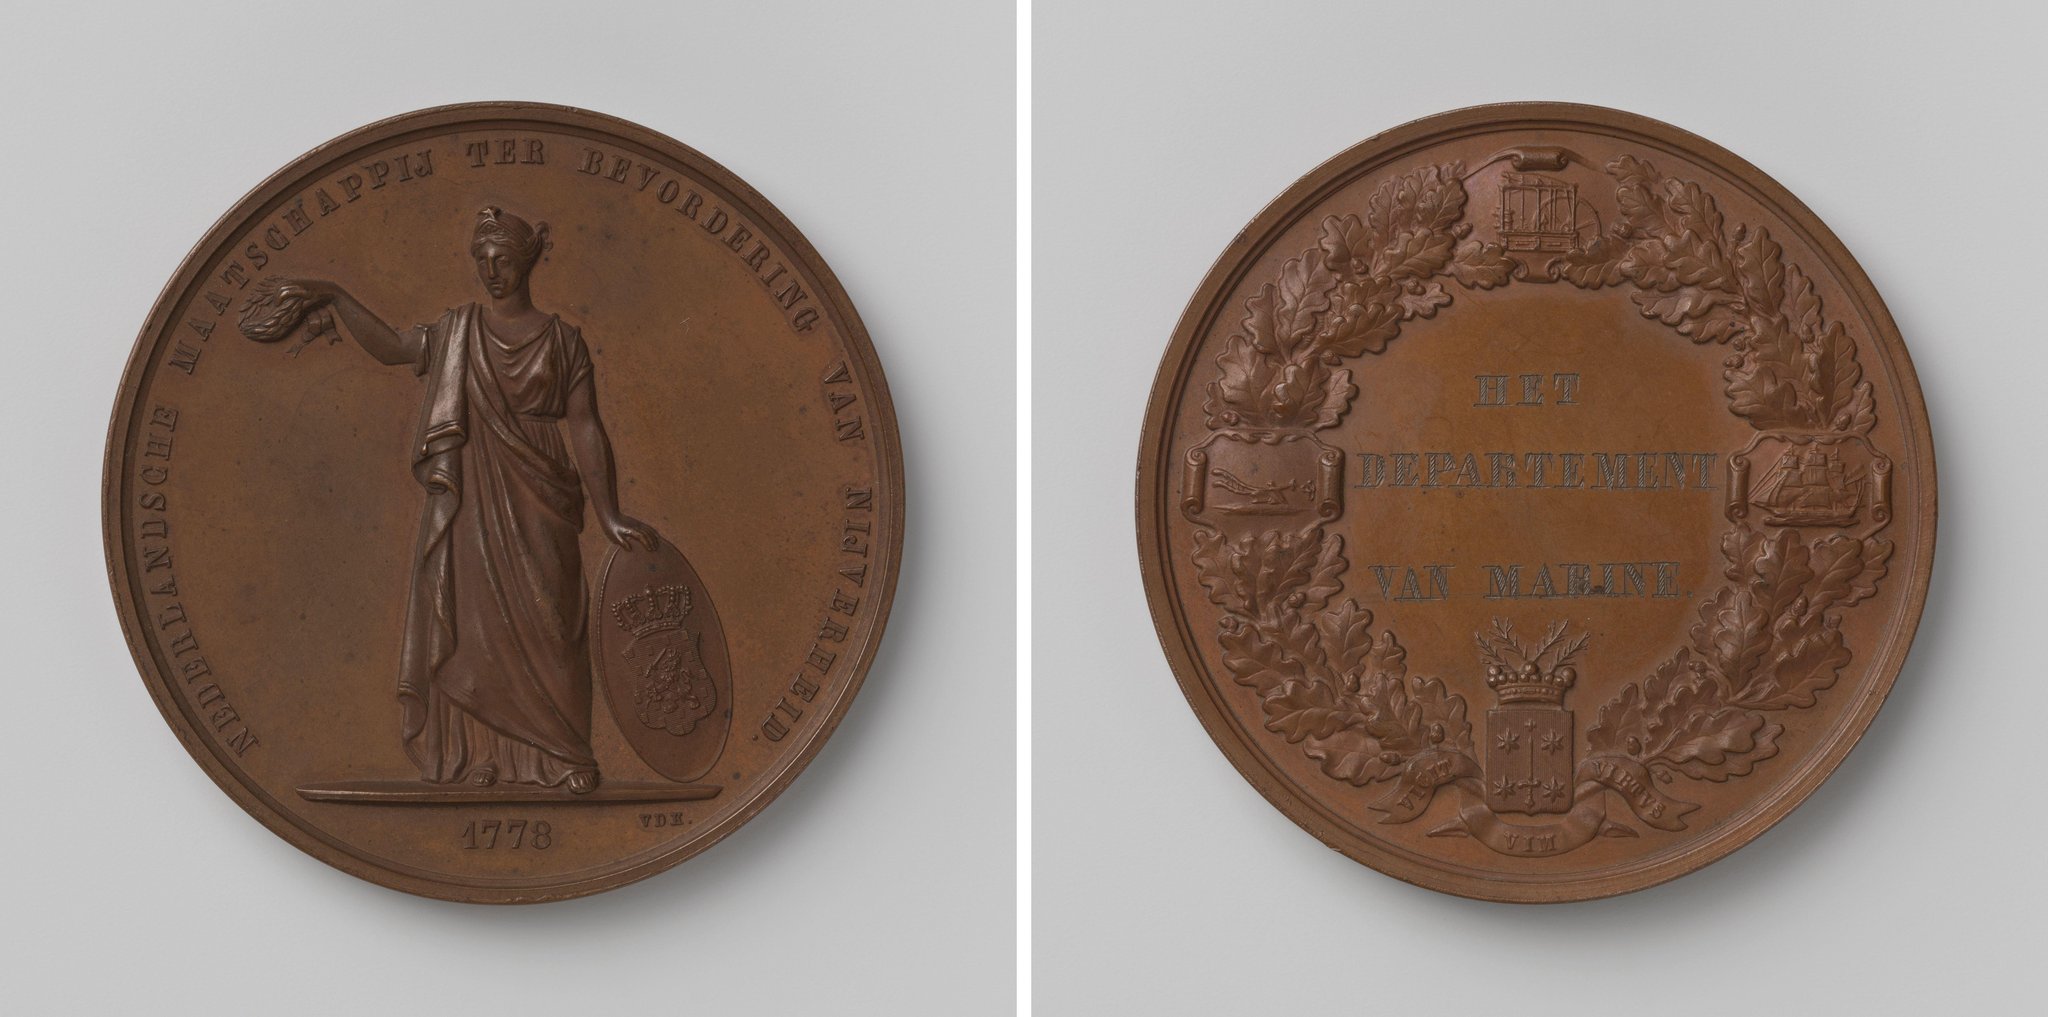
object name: medal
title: Algemeene Nationale tentoonstelling van Nijverheid te Haarlem, georganiseerd door de Maatschappij ter bevordering van Nijverheid, voorheen de Oeconomische Tak van de Hollandsche Maatschappij der Wetenschappen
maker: david van der kellen (1804-1879)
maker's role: die cutter, draughtsman, print maker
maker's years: 1804-1879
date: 1861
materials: bronze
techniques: engraving, striking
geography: utrecht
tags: department of the navy, haarlem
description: Bronzen penning. Voorzijde: vrouw in Romeinse kledij met diadeem op hoofd, voorstellende Nijverheid, houdt in haar uitgestrekte rechterhand een lauwerkrans en rust met haar andere hand op een wapenschild binnen omschrift; afsnede: jaartal en signatuur. Keerzijde: opschrift boven gekroond wapenschild binnen eikekrans, waaraan drie cartouches zijn bevestigd met daarin een ploeg, een driemaster en een stoommachine.